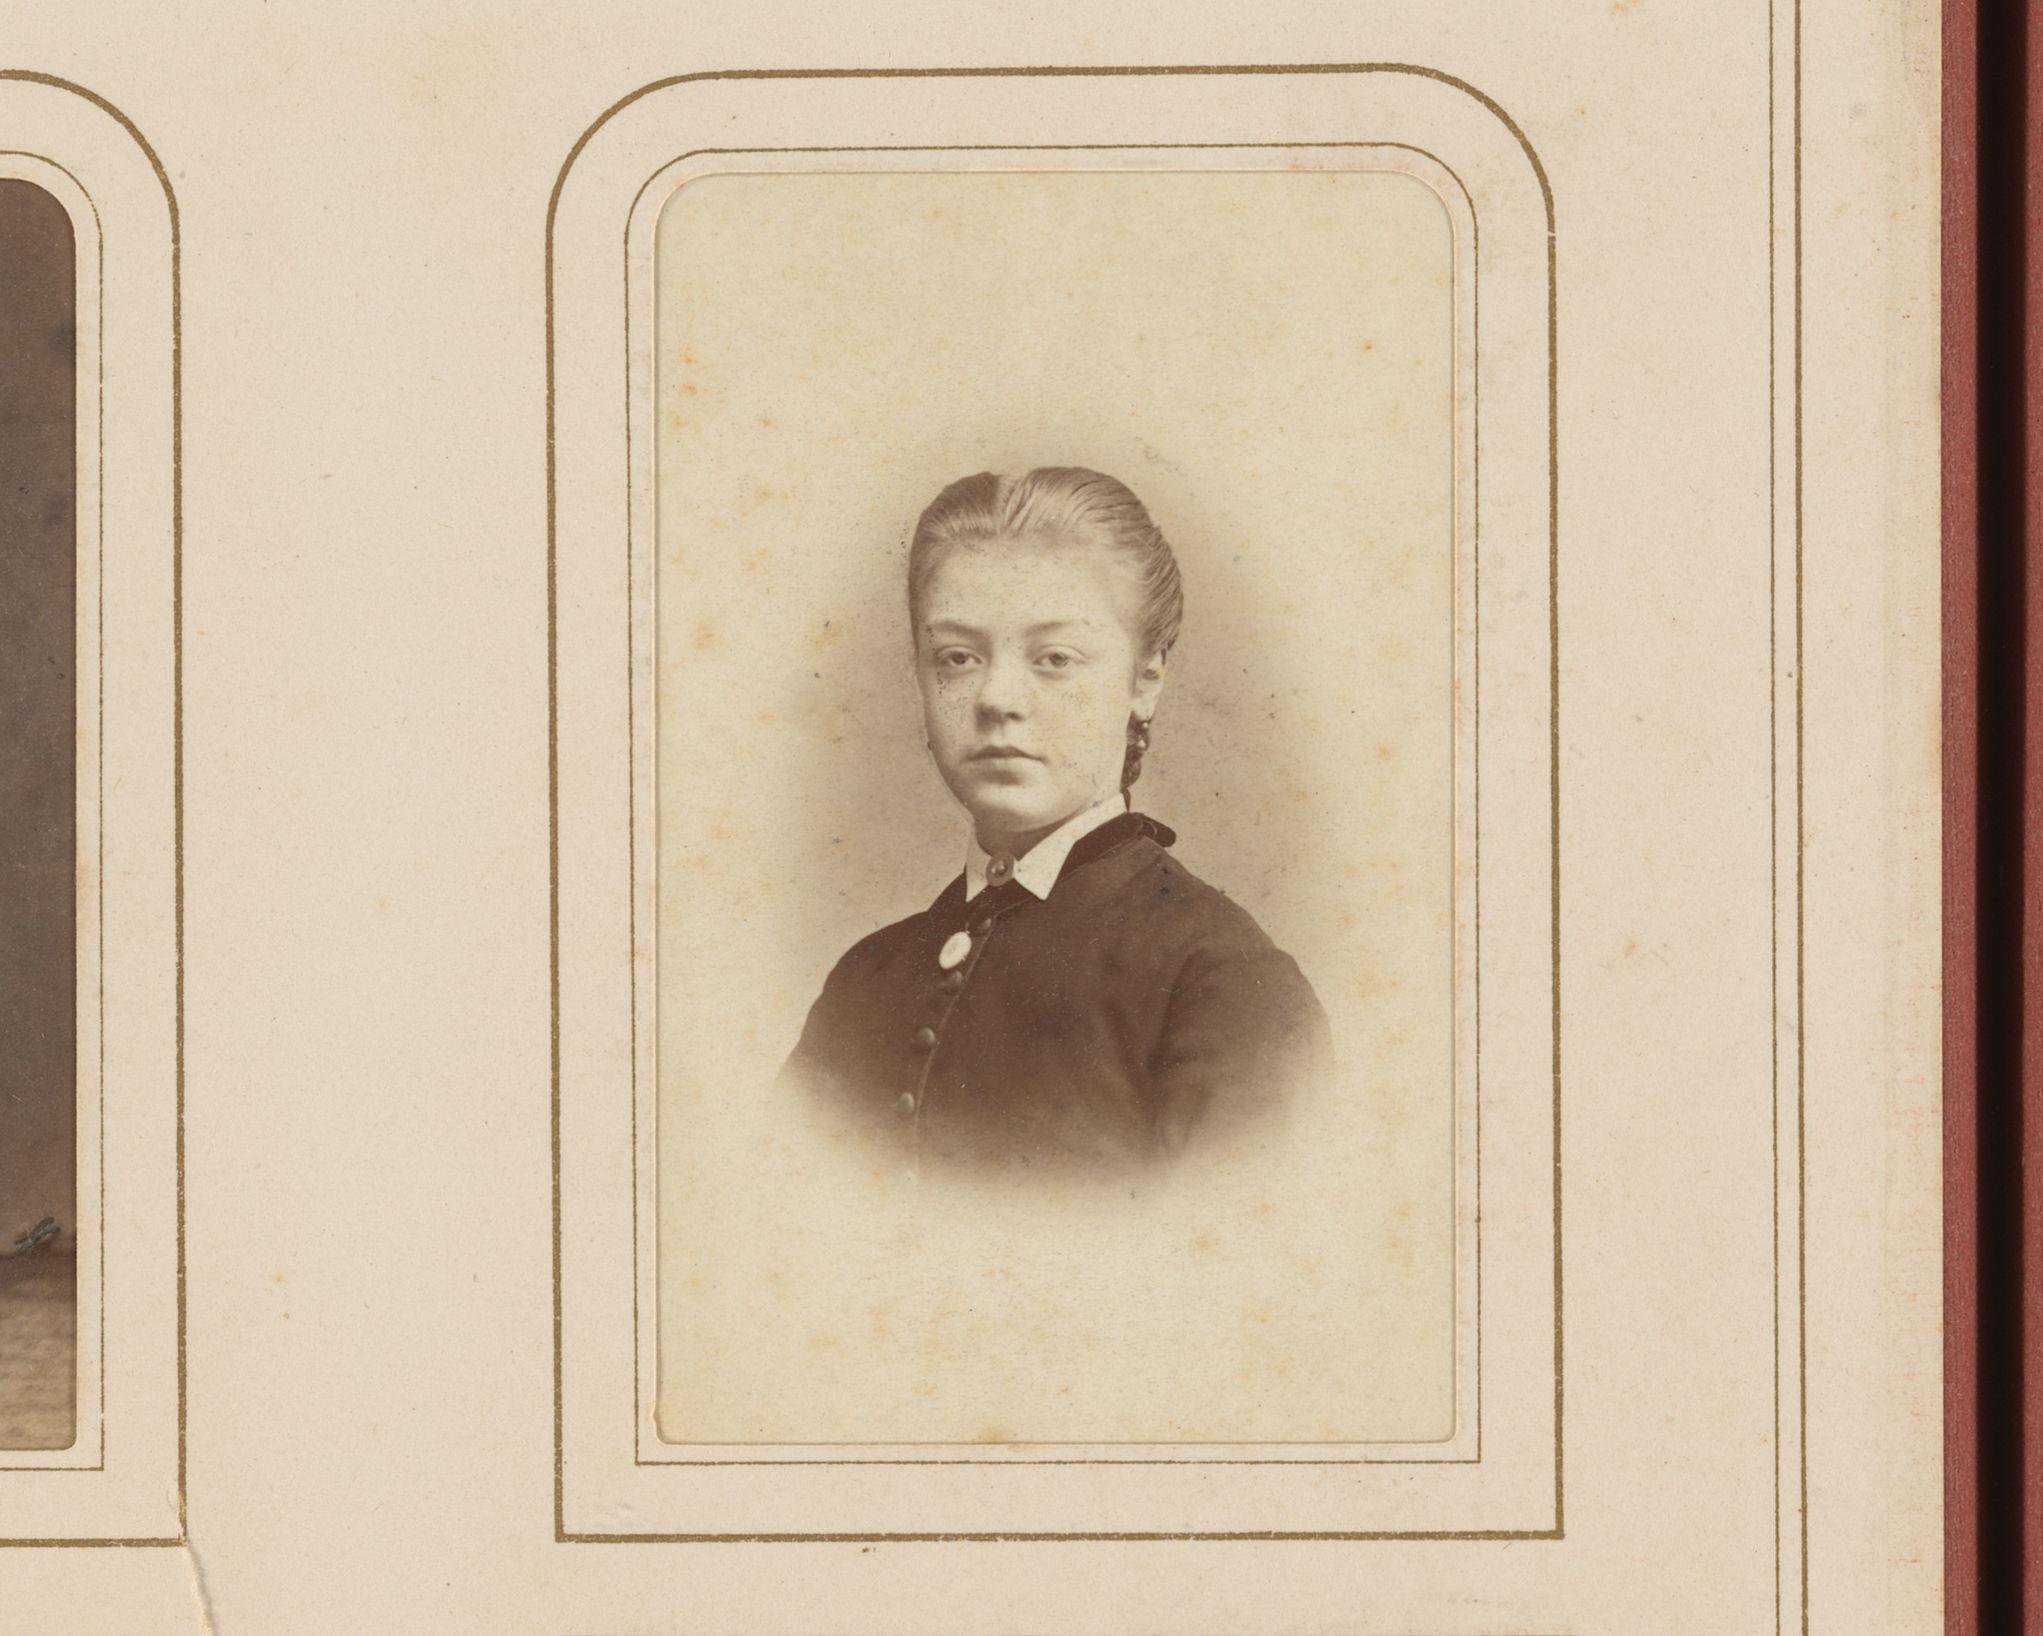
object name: carte de visite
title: Portret van een meisje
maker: johannes petrus oppers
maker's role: fotograaf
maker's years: 1833-1890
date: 1869-1890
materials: cardboard, photographic support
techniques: albumen print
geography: amsterdam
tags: historical persons - bb - woman, girl (child between toddler and youth)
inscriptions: inscription: ‘PHOTOGRAPHIE DE/ H. PH. J. SCHUITEN/ SUCCr. J. P. OPPERS/ AMSTERDAM’